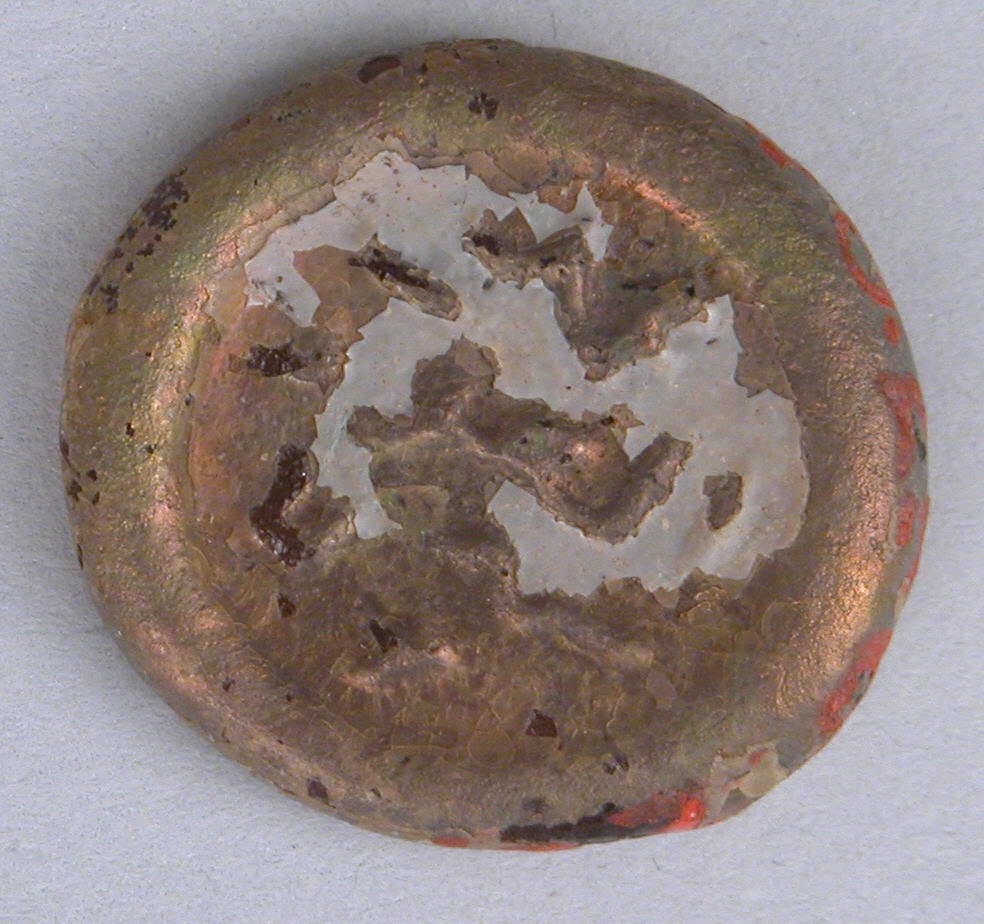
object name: coin weight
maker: muhammad al 'audi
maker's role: maker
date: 1001-1100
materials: glass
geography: egypt